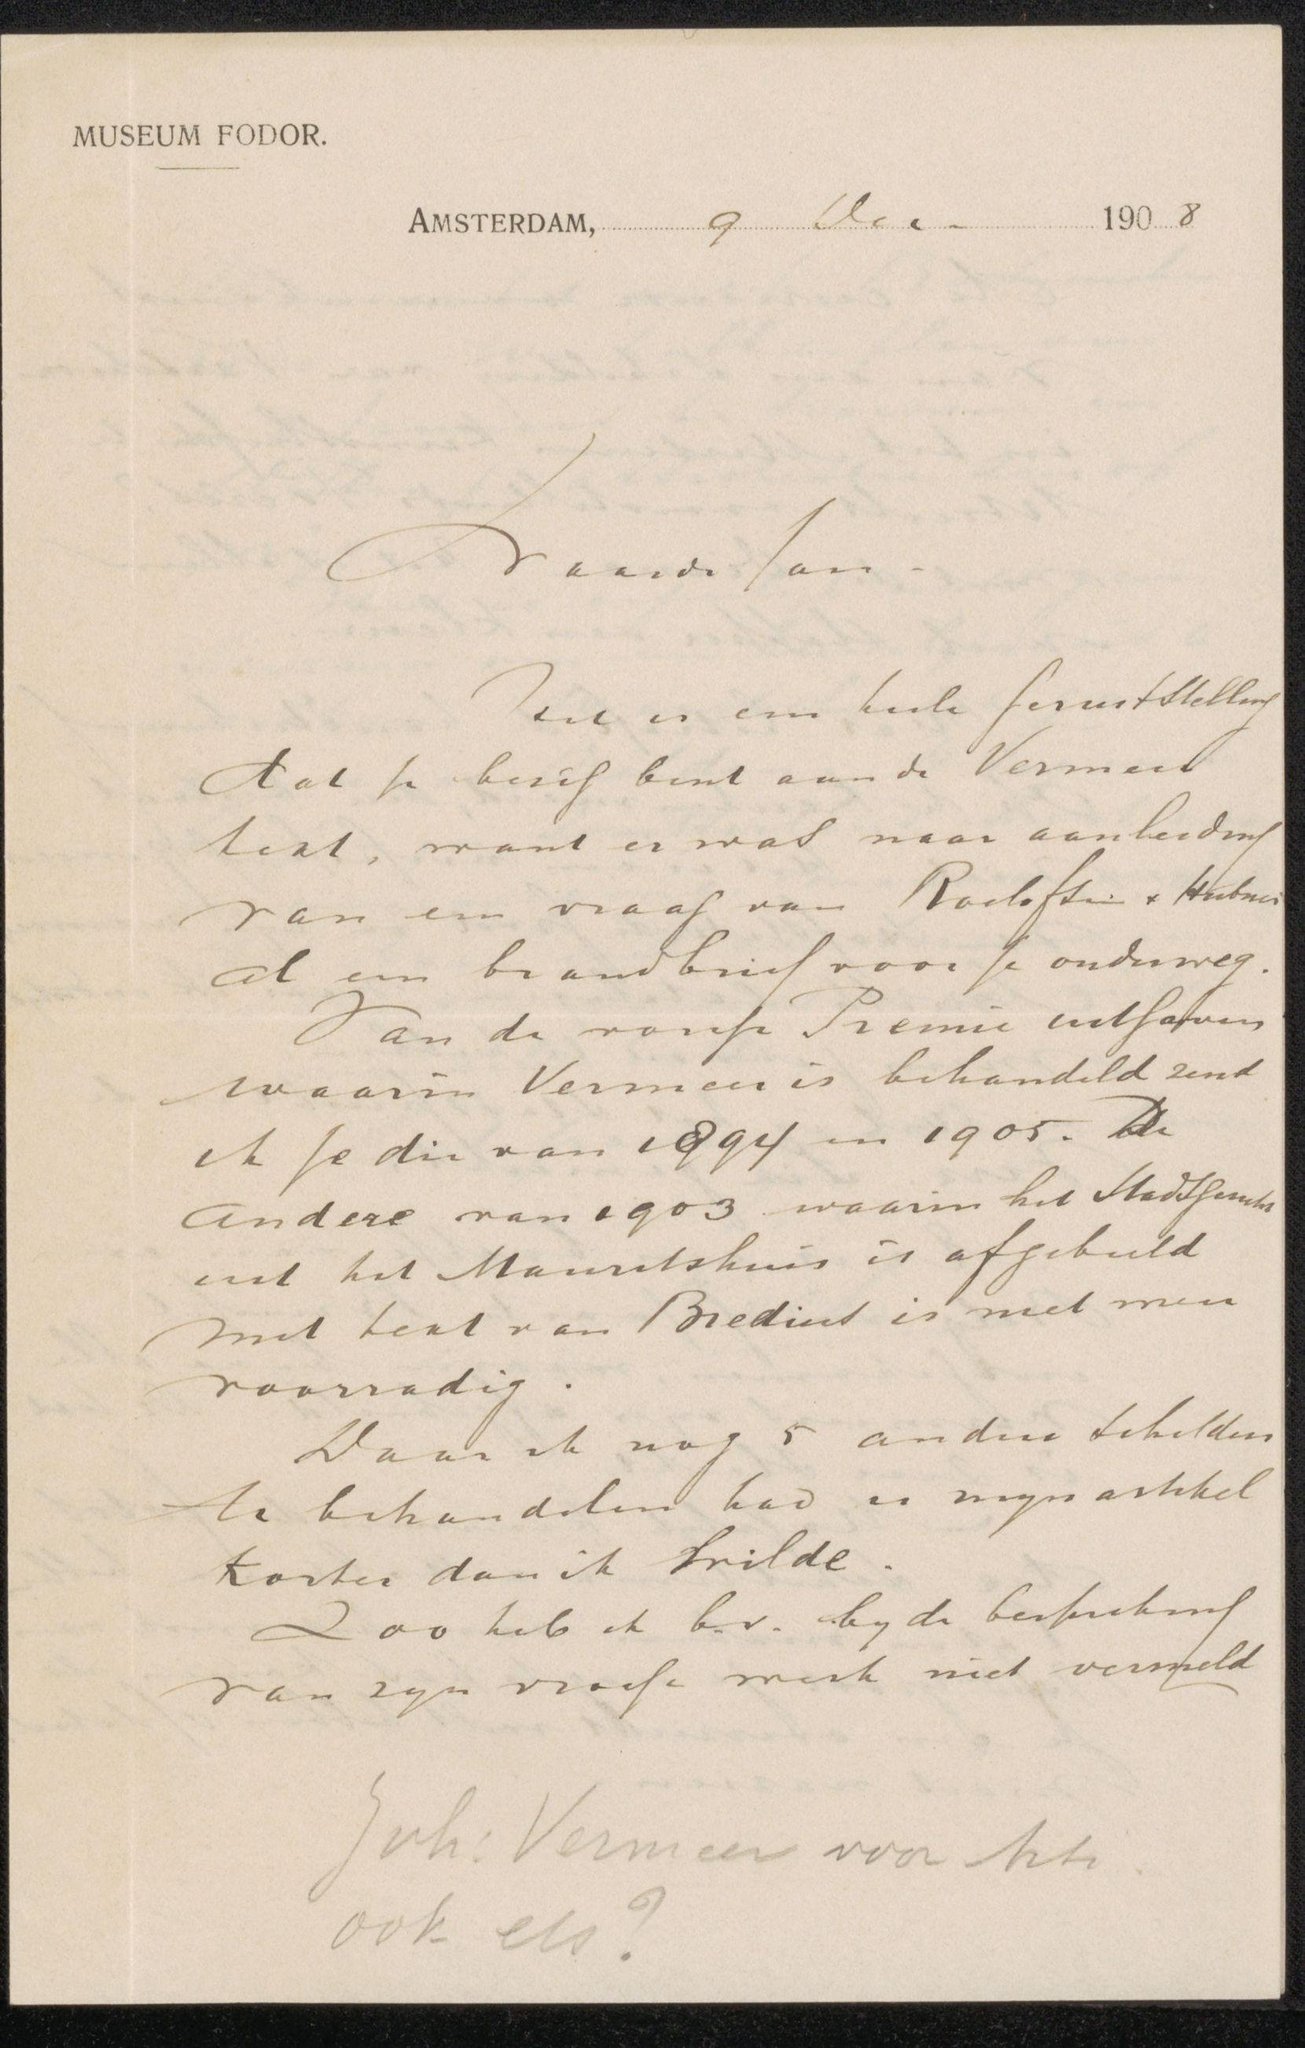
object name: letter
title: Brief aan Jan Veth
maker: cornelis gerardus t hooft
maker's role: draughtsman, painter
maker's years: 1866-1936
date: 1908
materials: ink, paper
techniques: pen, printing, writing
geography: amsterdam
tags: delft, painter, draughtsman, johannes vermeer, print maker, designer, jan veth, jonkheer jan six, abraham bredius, the hague, cornelis hofstede de groot, photography, cinematography, family life, travelling; tourism, painting (including book-illumination, miniature-painting), art collecting, printed matter, switzerland, berlin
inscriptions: collector's mark: ‘RPK’